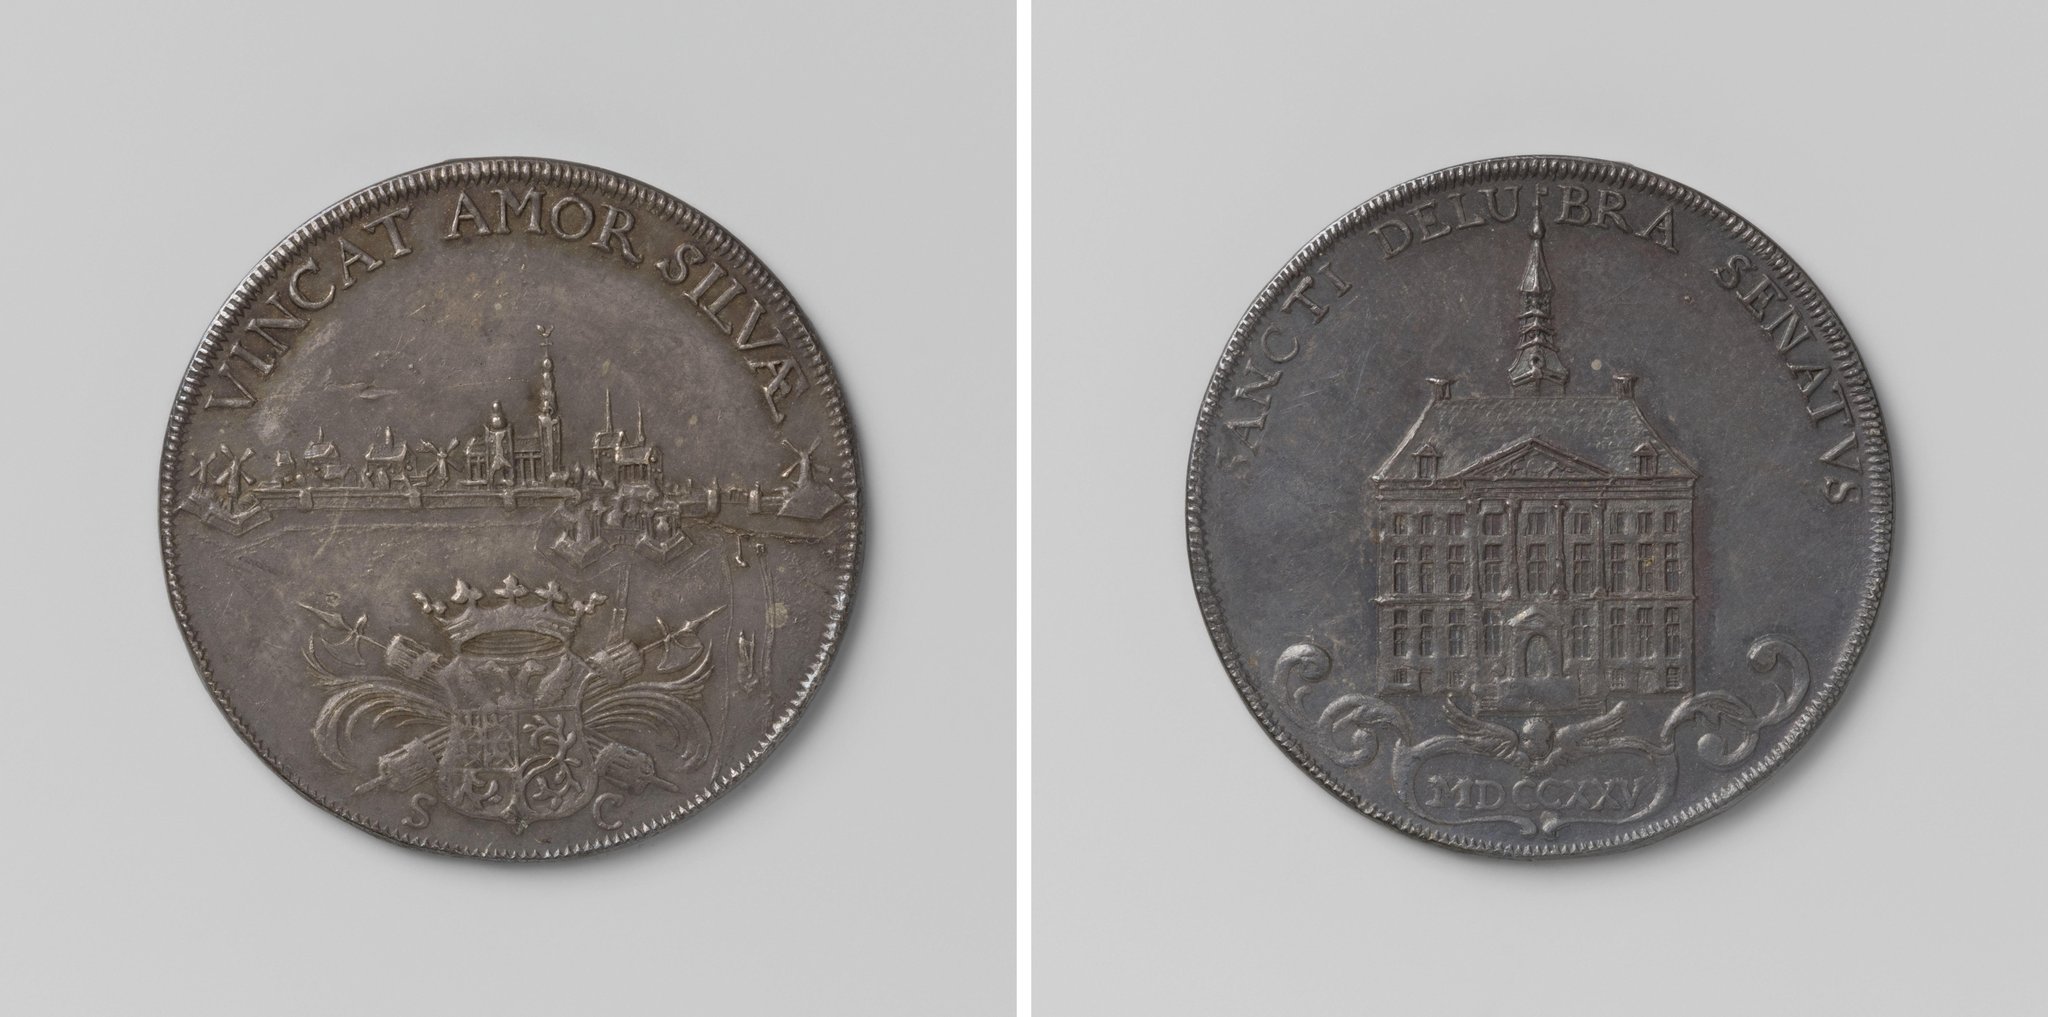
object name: council medal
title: Vroedschapspenning van de stad 's-Hertogenbosch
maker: theodorus casparus van berckel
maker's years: 1680-1734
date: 1725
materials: silver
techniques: striking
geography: den bosch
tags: den bosch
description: Zilveren penning. Voorzijde: gezicht op stad vanaf de noordzijde en de Dieze met twee scheepjes; op voorgrond: gekroond wapenschild op twee gekruiste roedebundels met bijlen en twee palmtakken tussen monogram van de letters S en C binnen omschrift. Keerzijde: stadhuis boven cartouche met jaartal onder gevleugeld engelenkopje binnen omschrift.